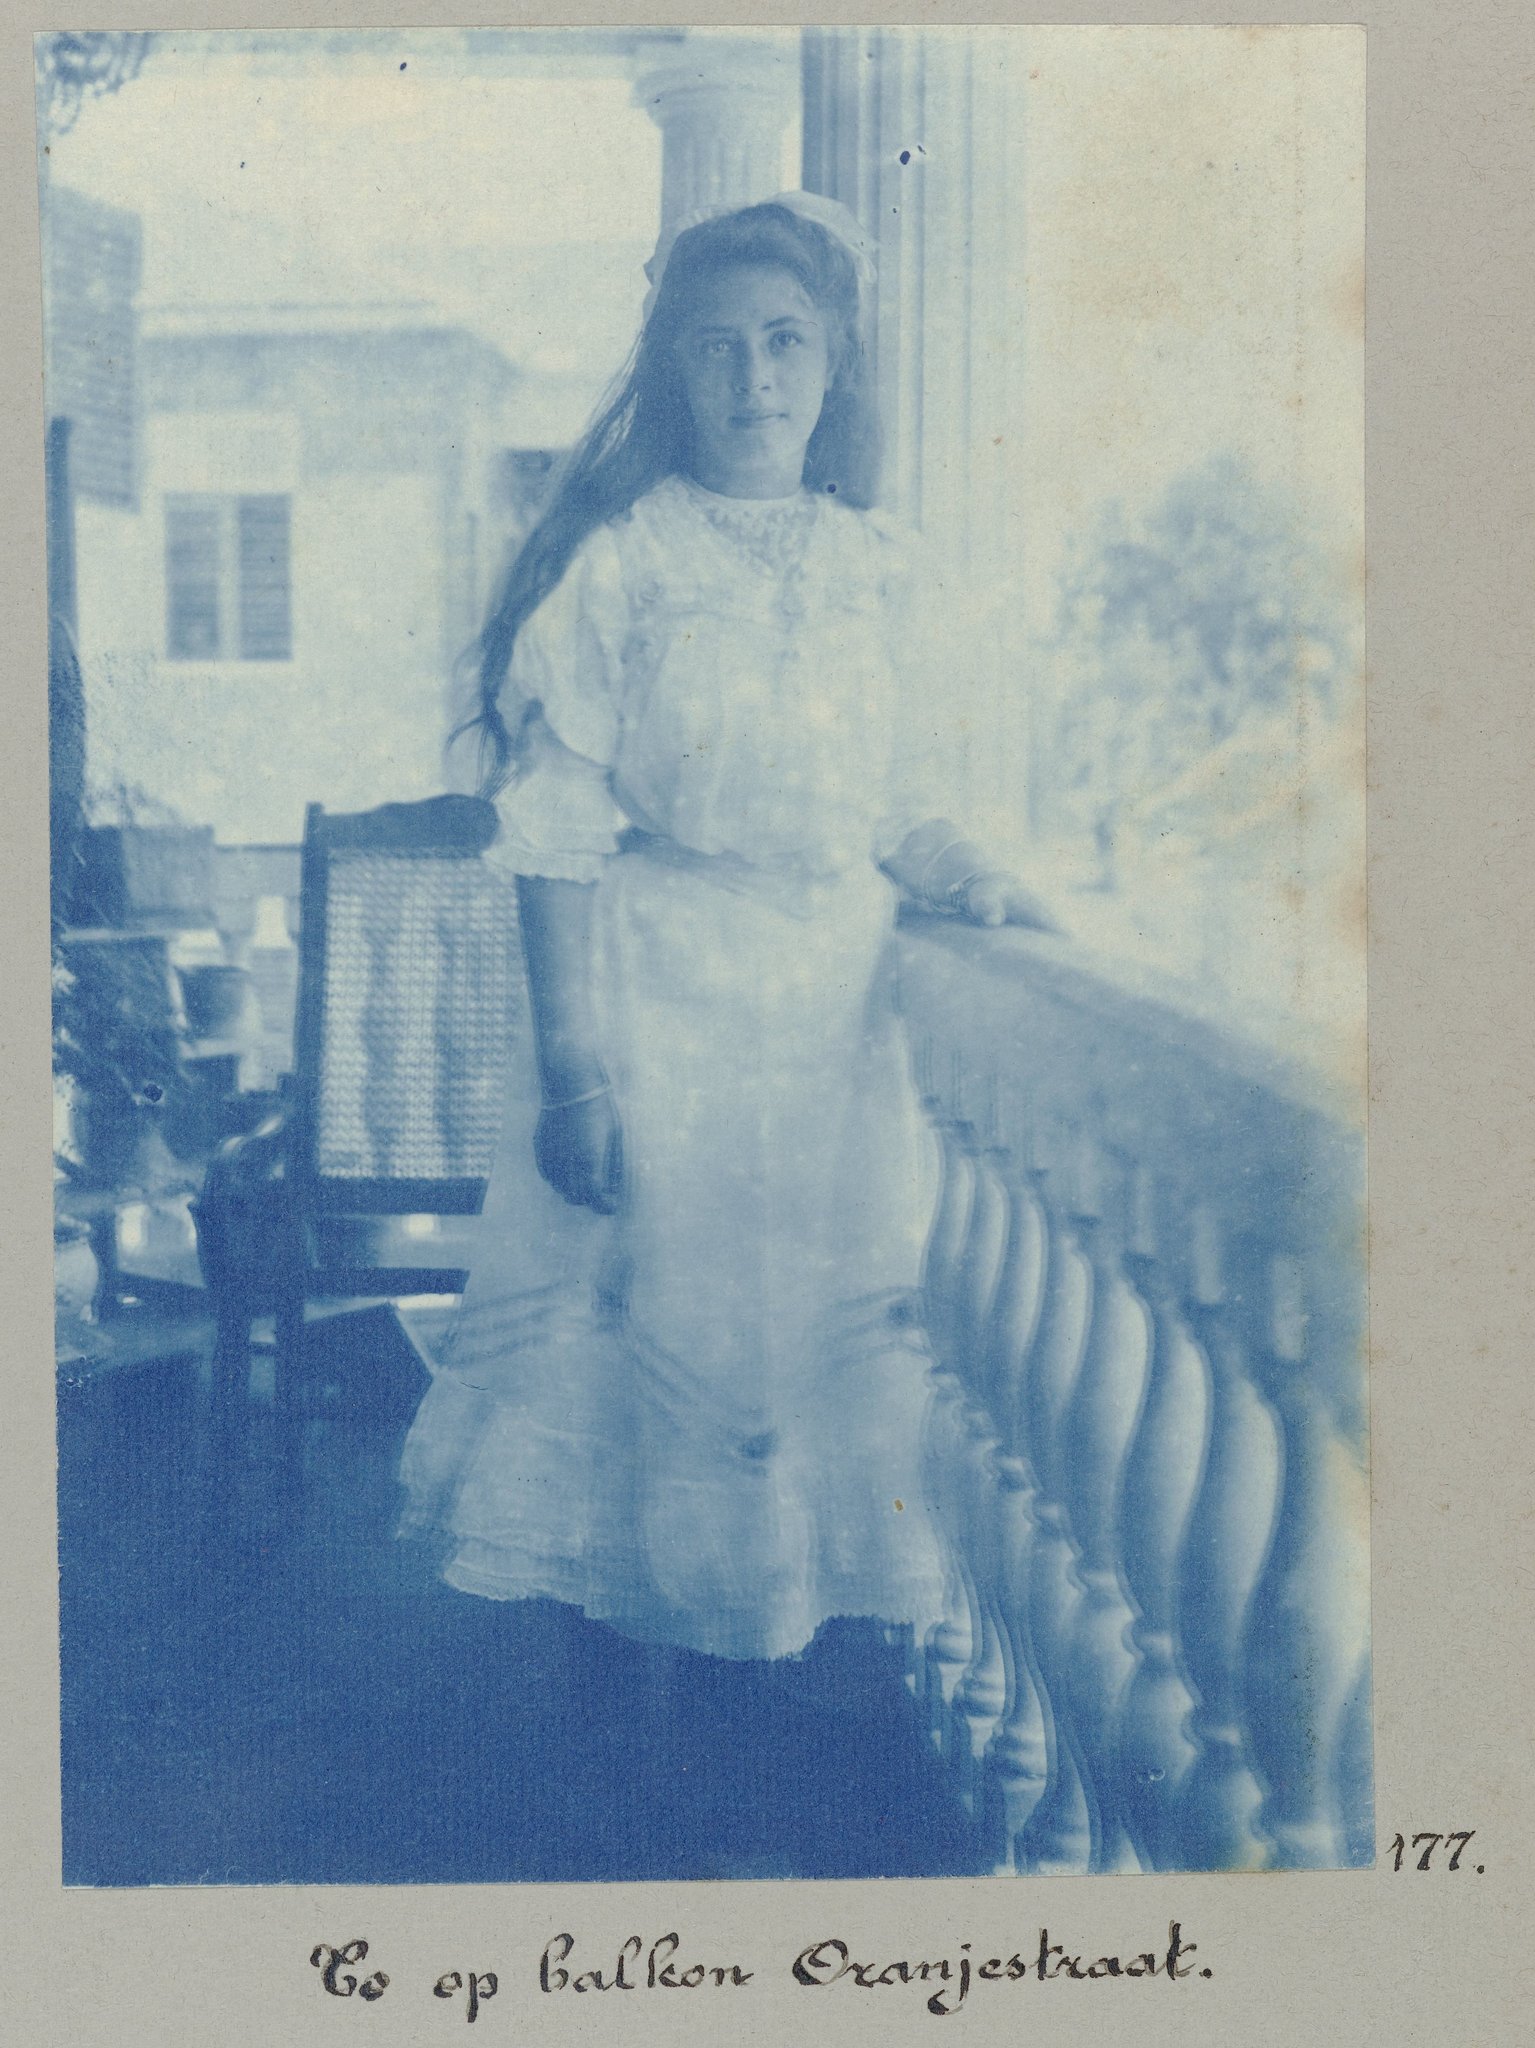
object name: photograph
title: To op balkon Oranjestraat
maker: hendrik doijer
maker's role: engineer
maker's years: 1863-1925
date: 1903-1910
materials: photographic support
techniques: cyanotype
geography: suriname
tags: suriname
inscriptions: inscription: ‘177. / To op balkon Oranjestraat.’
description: De jonge Nederlandse vrouw genaamd To, staande op het balkon van het huis aan de Oranjestraat te Paramaribo. Onderdeel van het fotoalbum Souvenir de Voyage (deel 5), over het leven van de familie Doijer in en rond de plantage Ma Retraite in Suriname in de jaren 1903-1910.